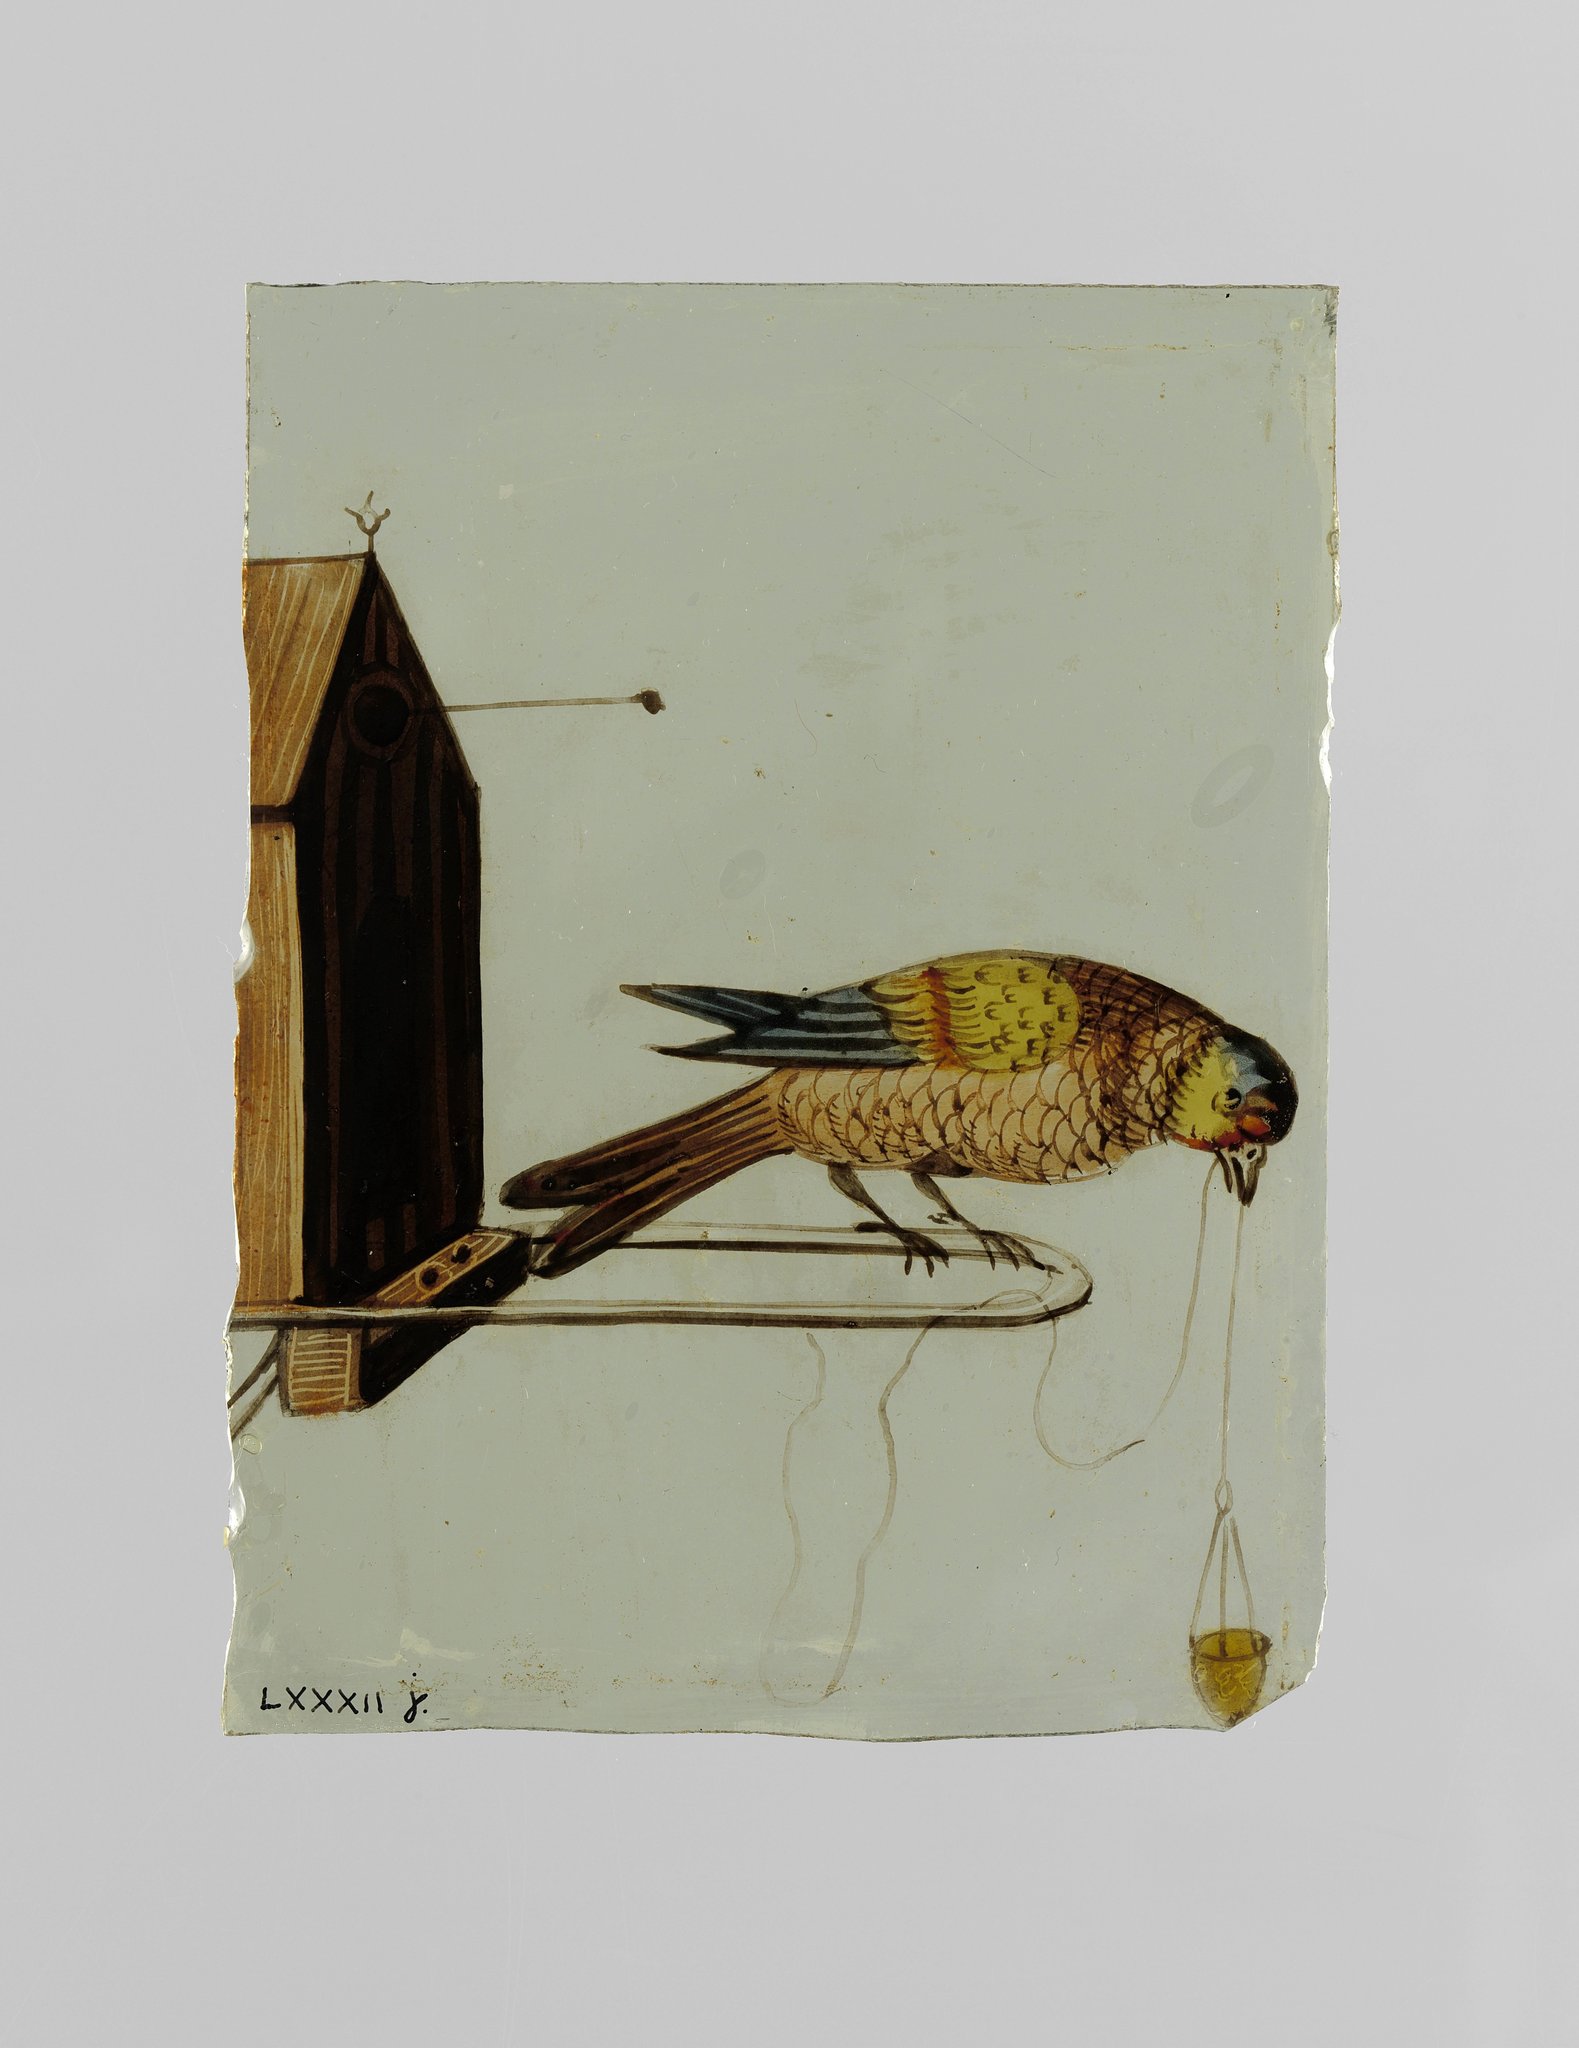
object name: light window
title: Ruit met een fantasievogel voor een vogelhuisje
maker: Anonymous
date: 1650-1675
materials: glass, lead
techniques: enamel painting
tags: song-birds: goldfinch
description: Een ruit met emailschildering van een vogelhuisje met een puttertje. De vogel heeft een touw in zijn snavel waaraan een miniatuur wateremmertje hangt.